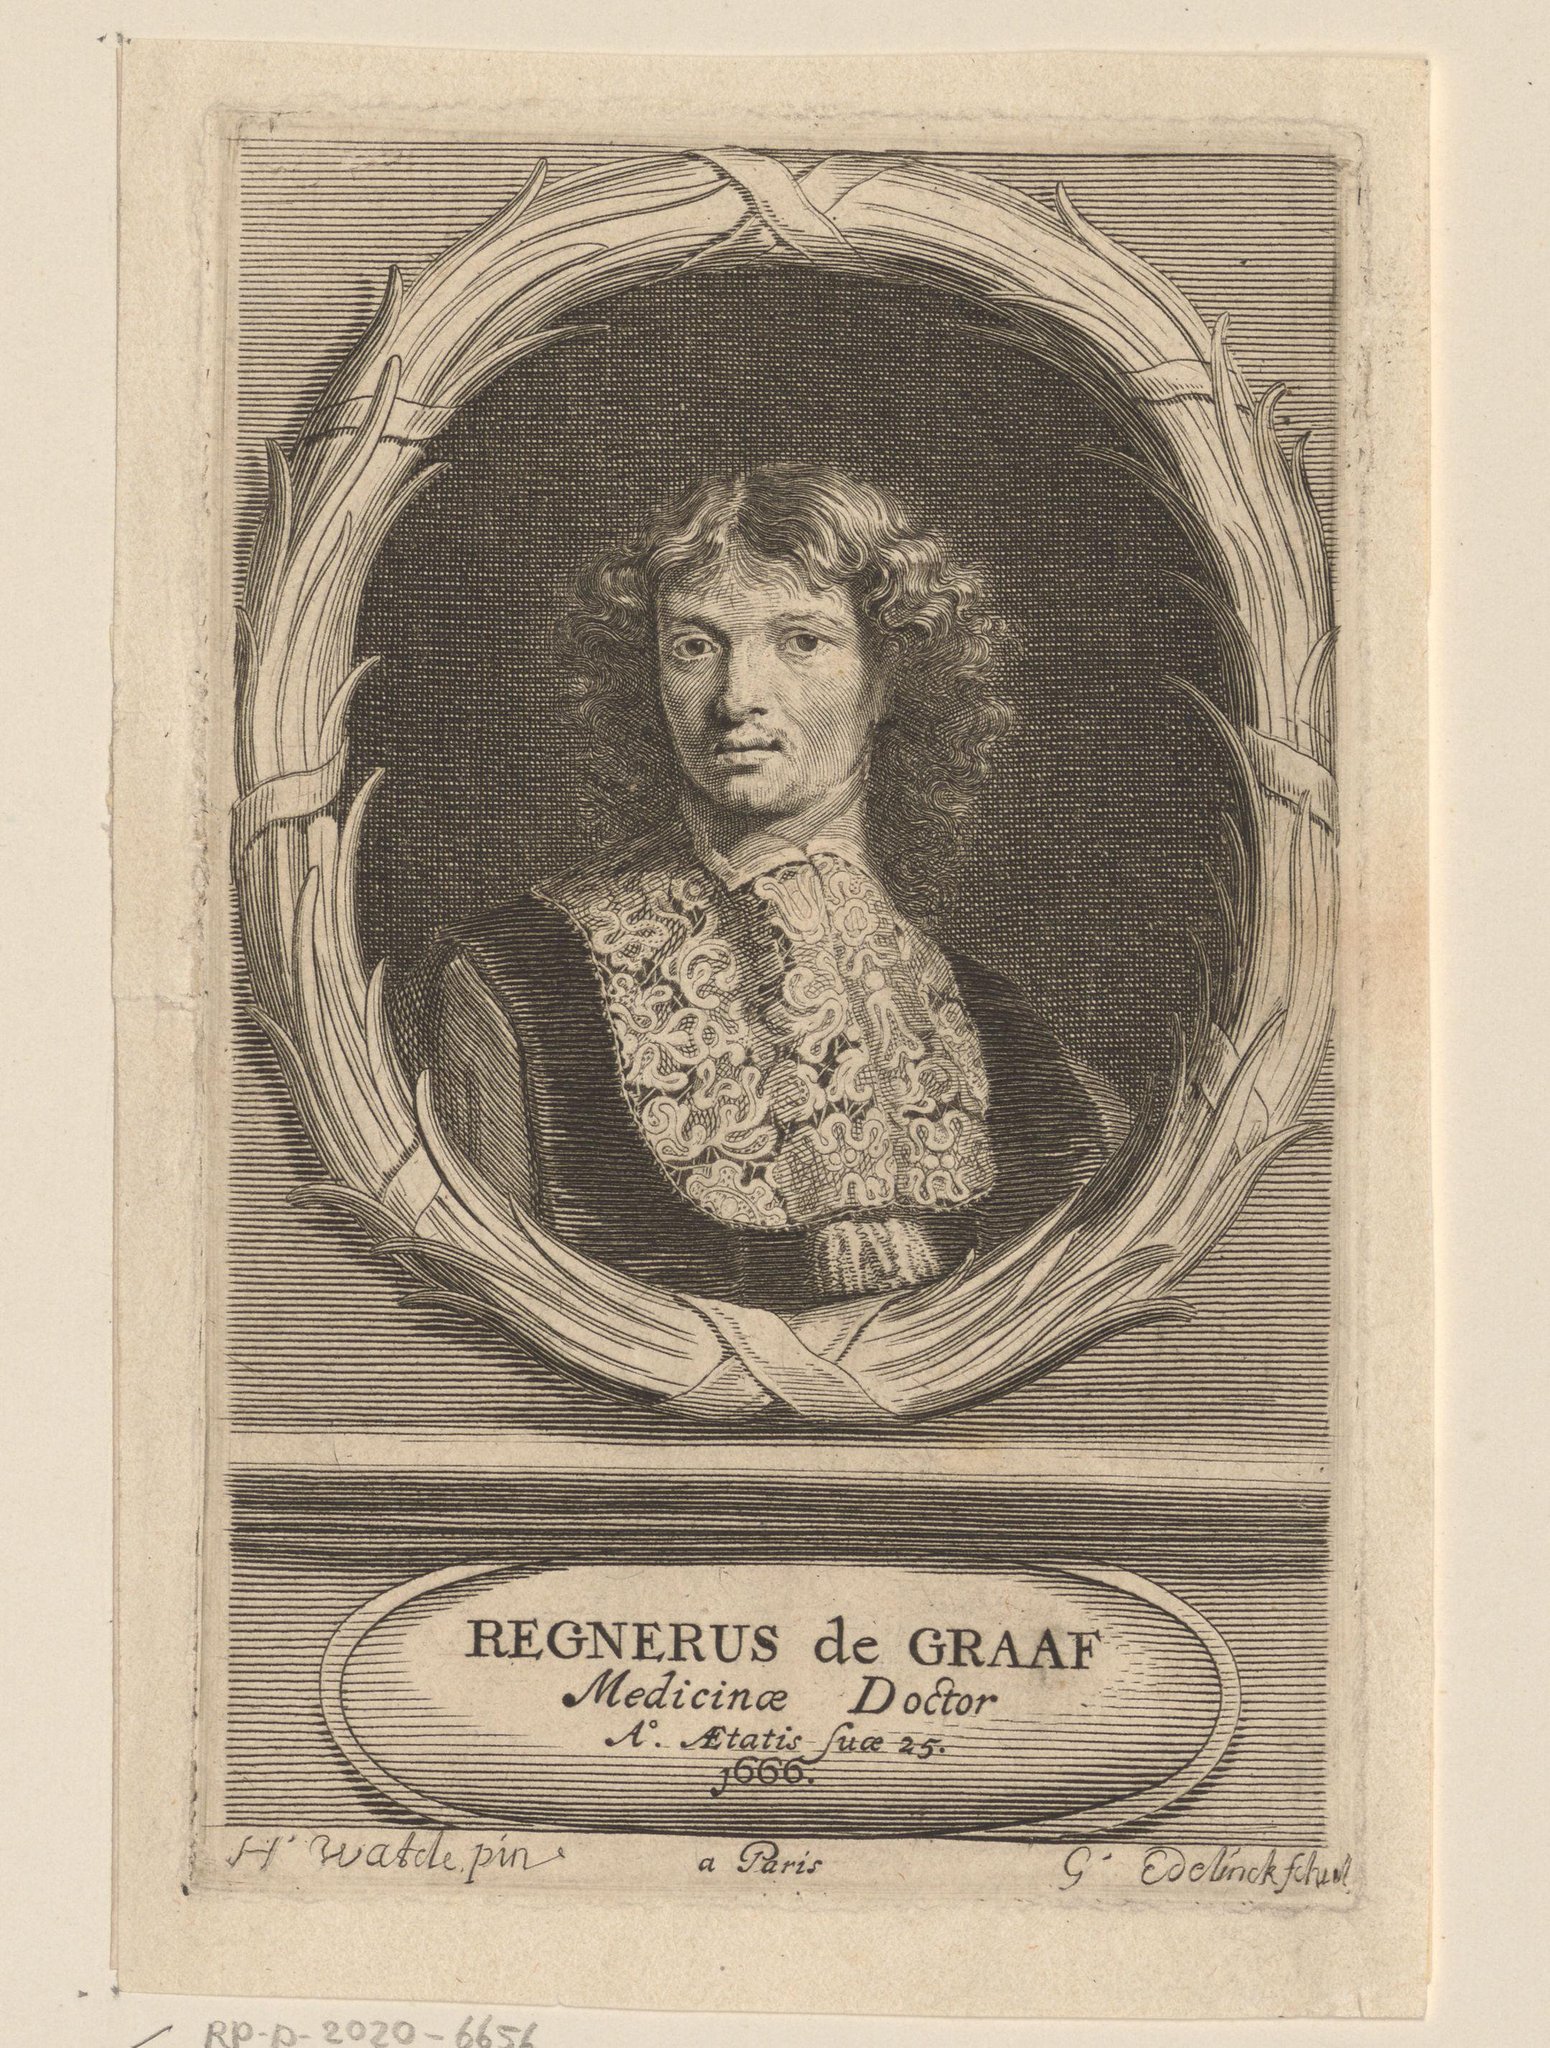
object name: print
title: Portret van Reinier de Graaf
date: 1666-1707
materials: paper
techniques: engraving, etching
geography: paris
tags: reinier de graaf, historical persons, writer, poet, author